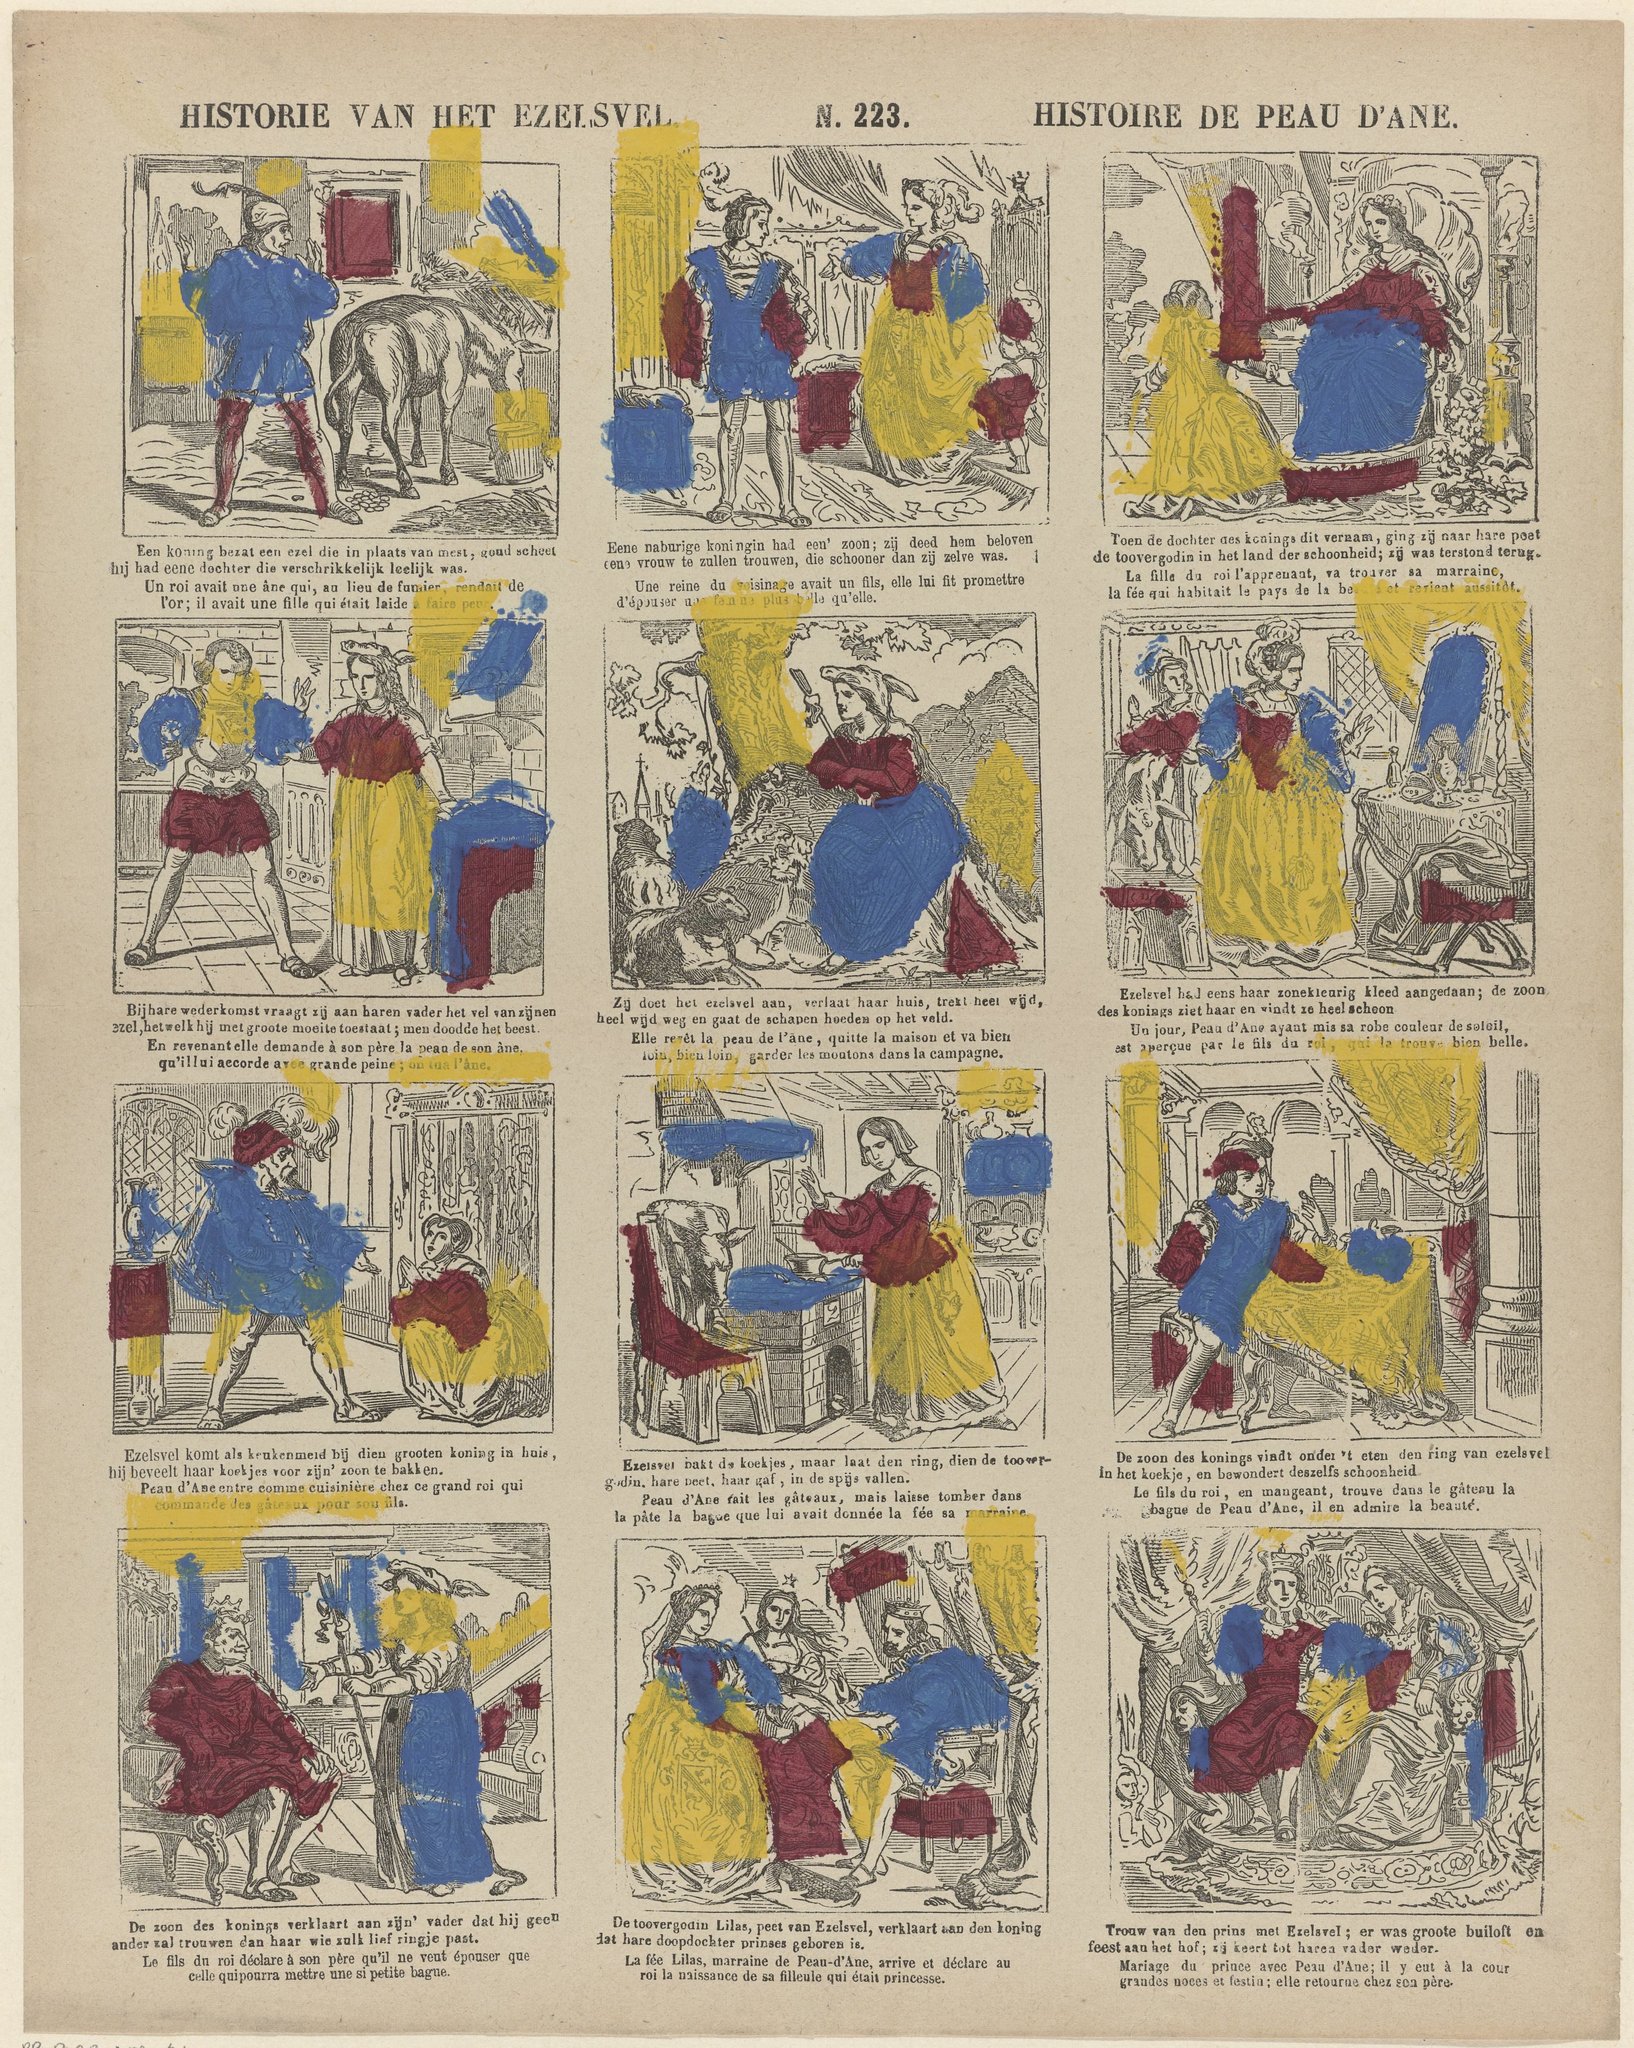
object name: print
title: Historie van het ezelsvel / Histoire de peau d'ane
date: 1800-1833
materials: paper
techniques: colour, letterpress printing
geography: turnhout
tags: ass, donkey, tales and fairy tales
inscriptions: collector's mark: Lugt 2760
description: Blad met 12 voorstellingen uit het sprookje van Ezelsvel. Onder elke voorstelling een onderschrift in het Nederlands en in het Frans. Genummerd midden boven: N. 223.